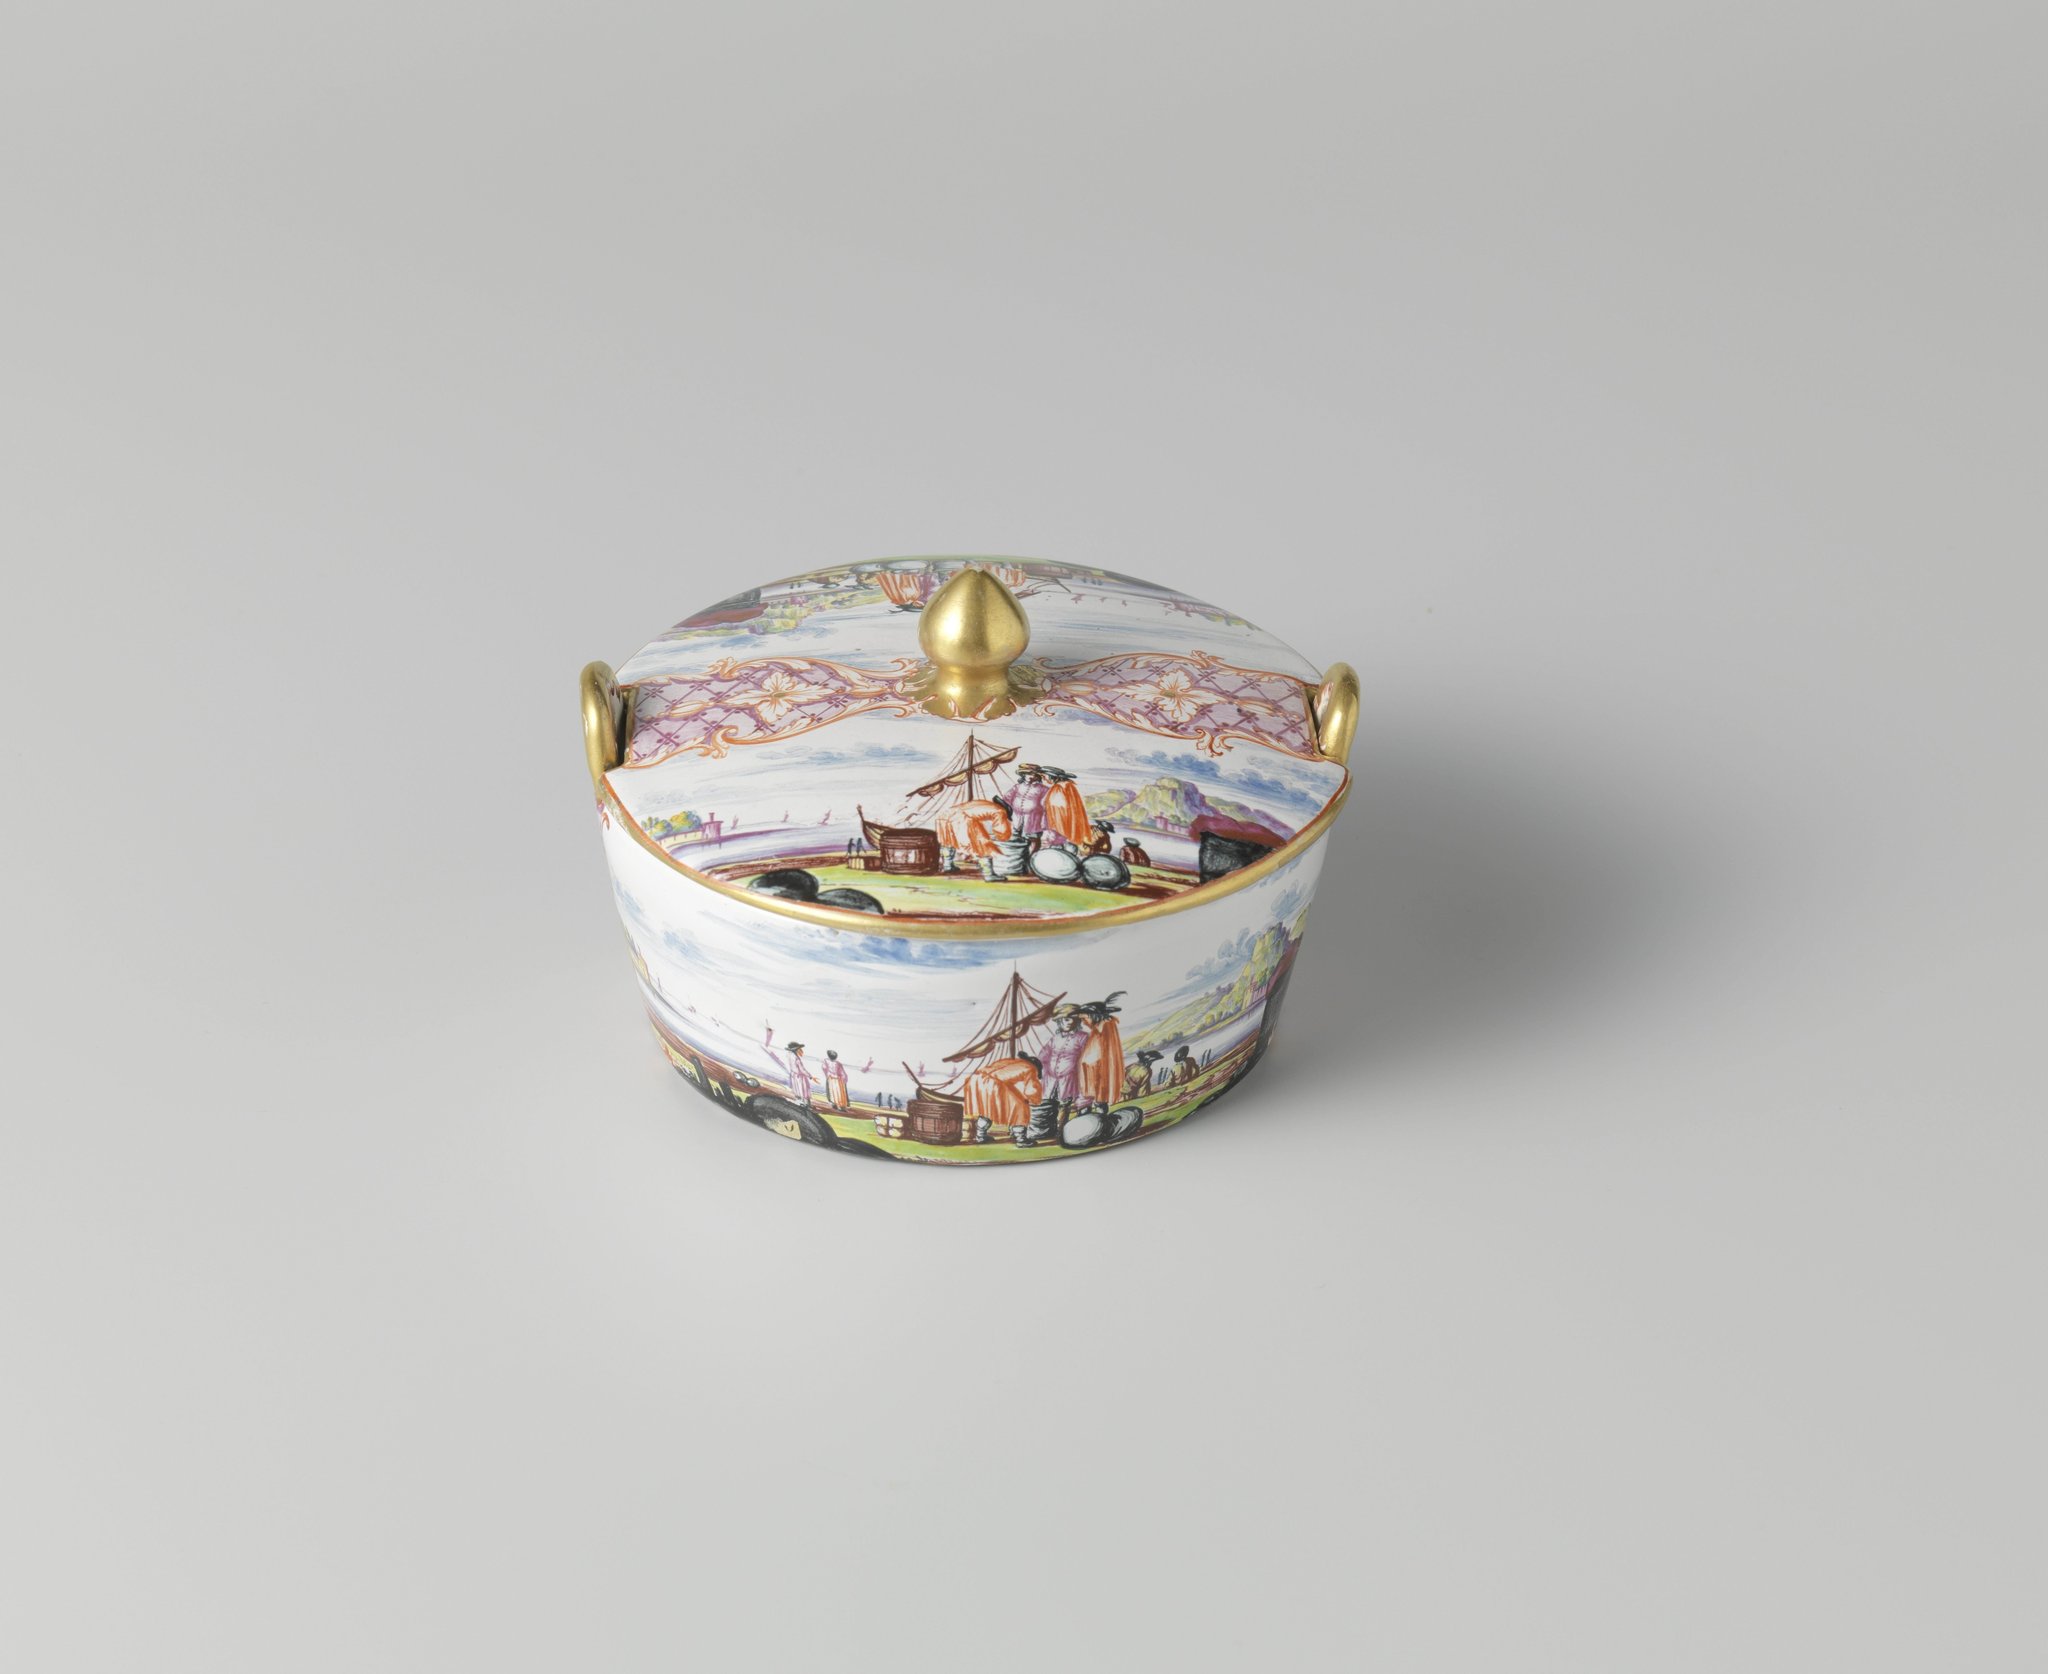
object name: butter dish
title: Botervloot, veelkleurig beschilderd met een mediterraan landschap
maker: Anonymous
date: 1735-1755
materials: faience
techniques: kiln, painted, polychromy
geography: delft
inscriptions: mark: ‘VA’, collector's mark: ‘collection J.F. Loudon’, inscription: ‘9’, inscription: ‘9’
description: Rond botervlootje met opstaande oortjes veelkleurig beschilderd met een mediterraan landschap. Gemerkt in blauw VA.